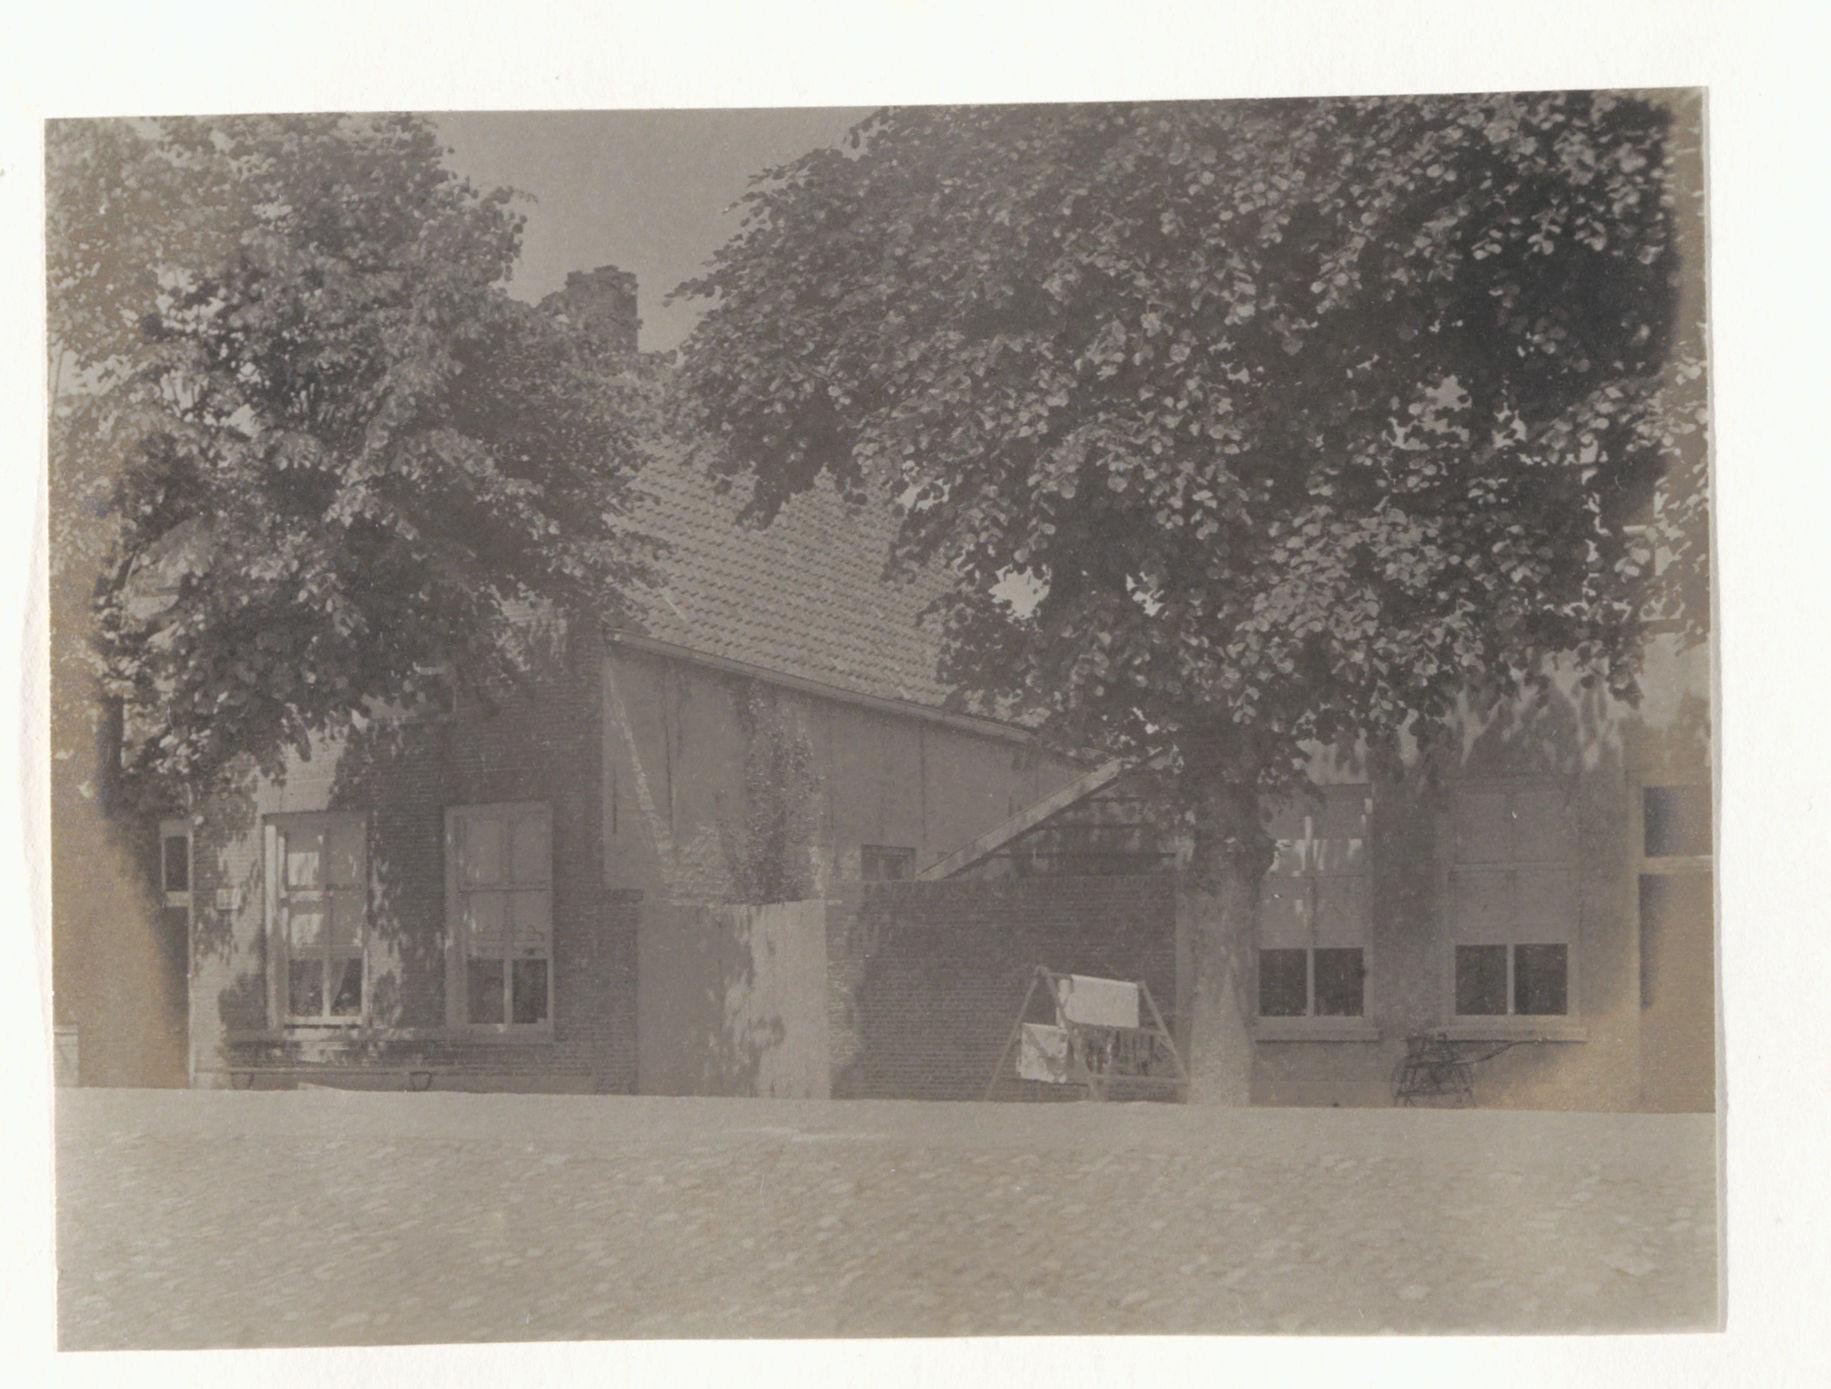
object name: photograph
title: Huizen met drogend wasgoed ervoor, vermoedelijk in Volendam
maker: george hidderley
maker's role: fotograaf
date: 1900-1910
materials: paper, photographic support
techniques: gelatin silver print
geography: volendam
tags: hanging the wash to dry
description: Onderdeel van fotoalbum met opnames van Volendam, Dordrecht, Gorinchem en Woudrichem.